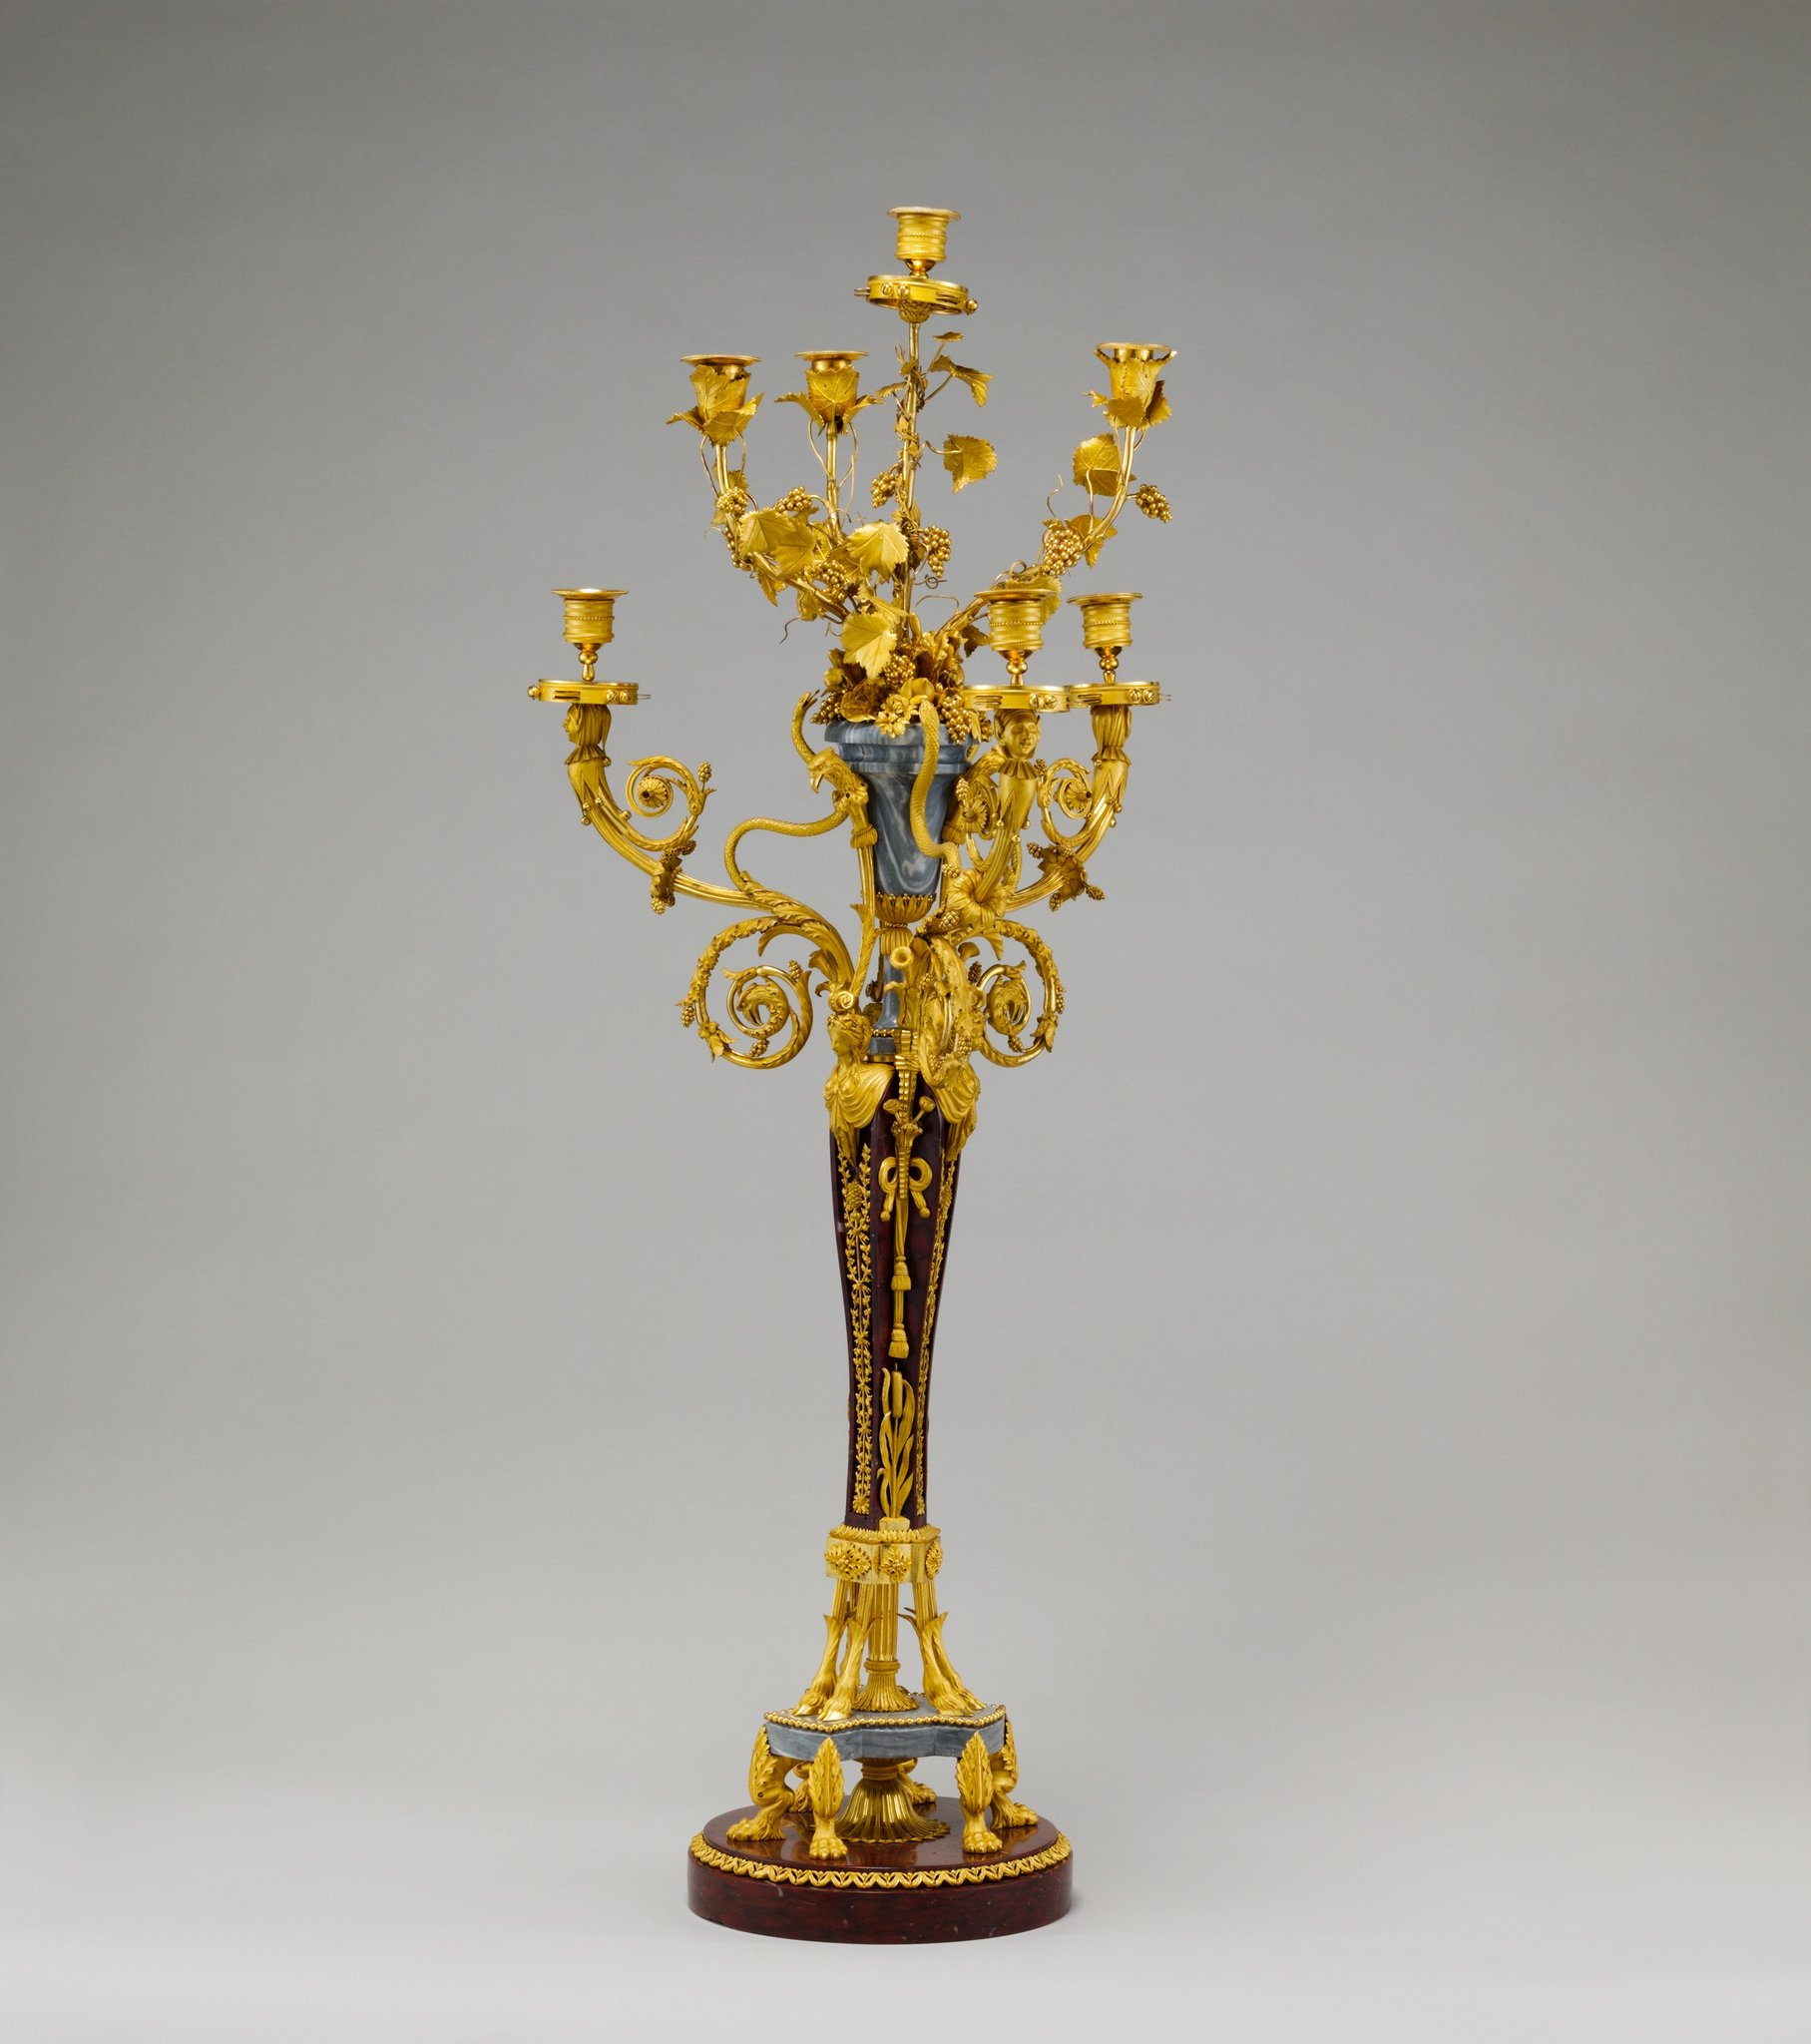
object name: candelabrum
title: Pair of seven-light candelabra (candélabres or girandoles)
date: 1790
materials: gilt bronze, marble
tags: grapes